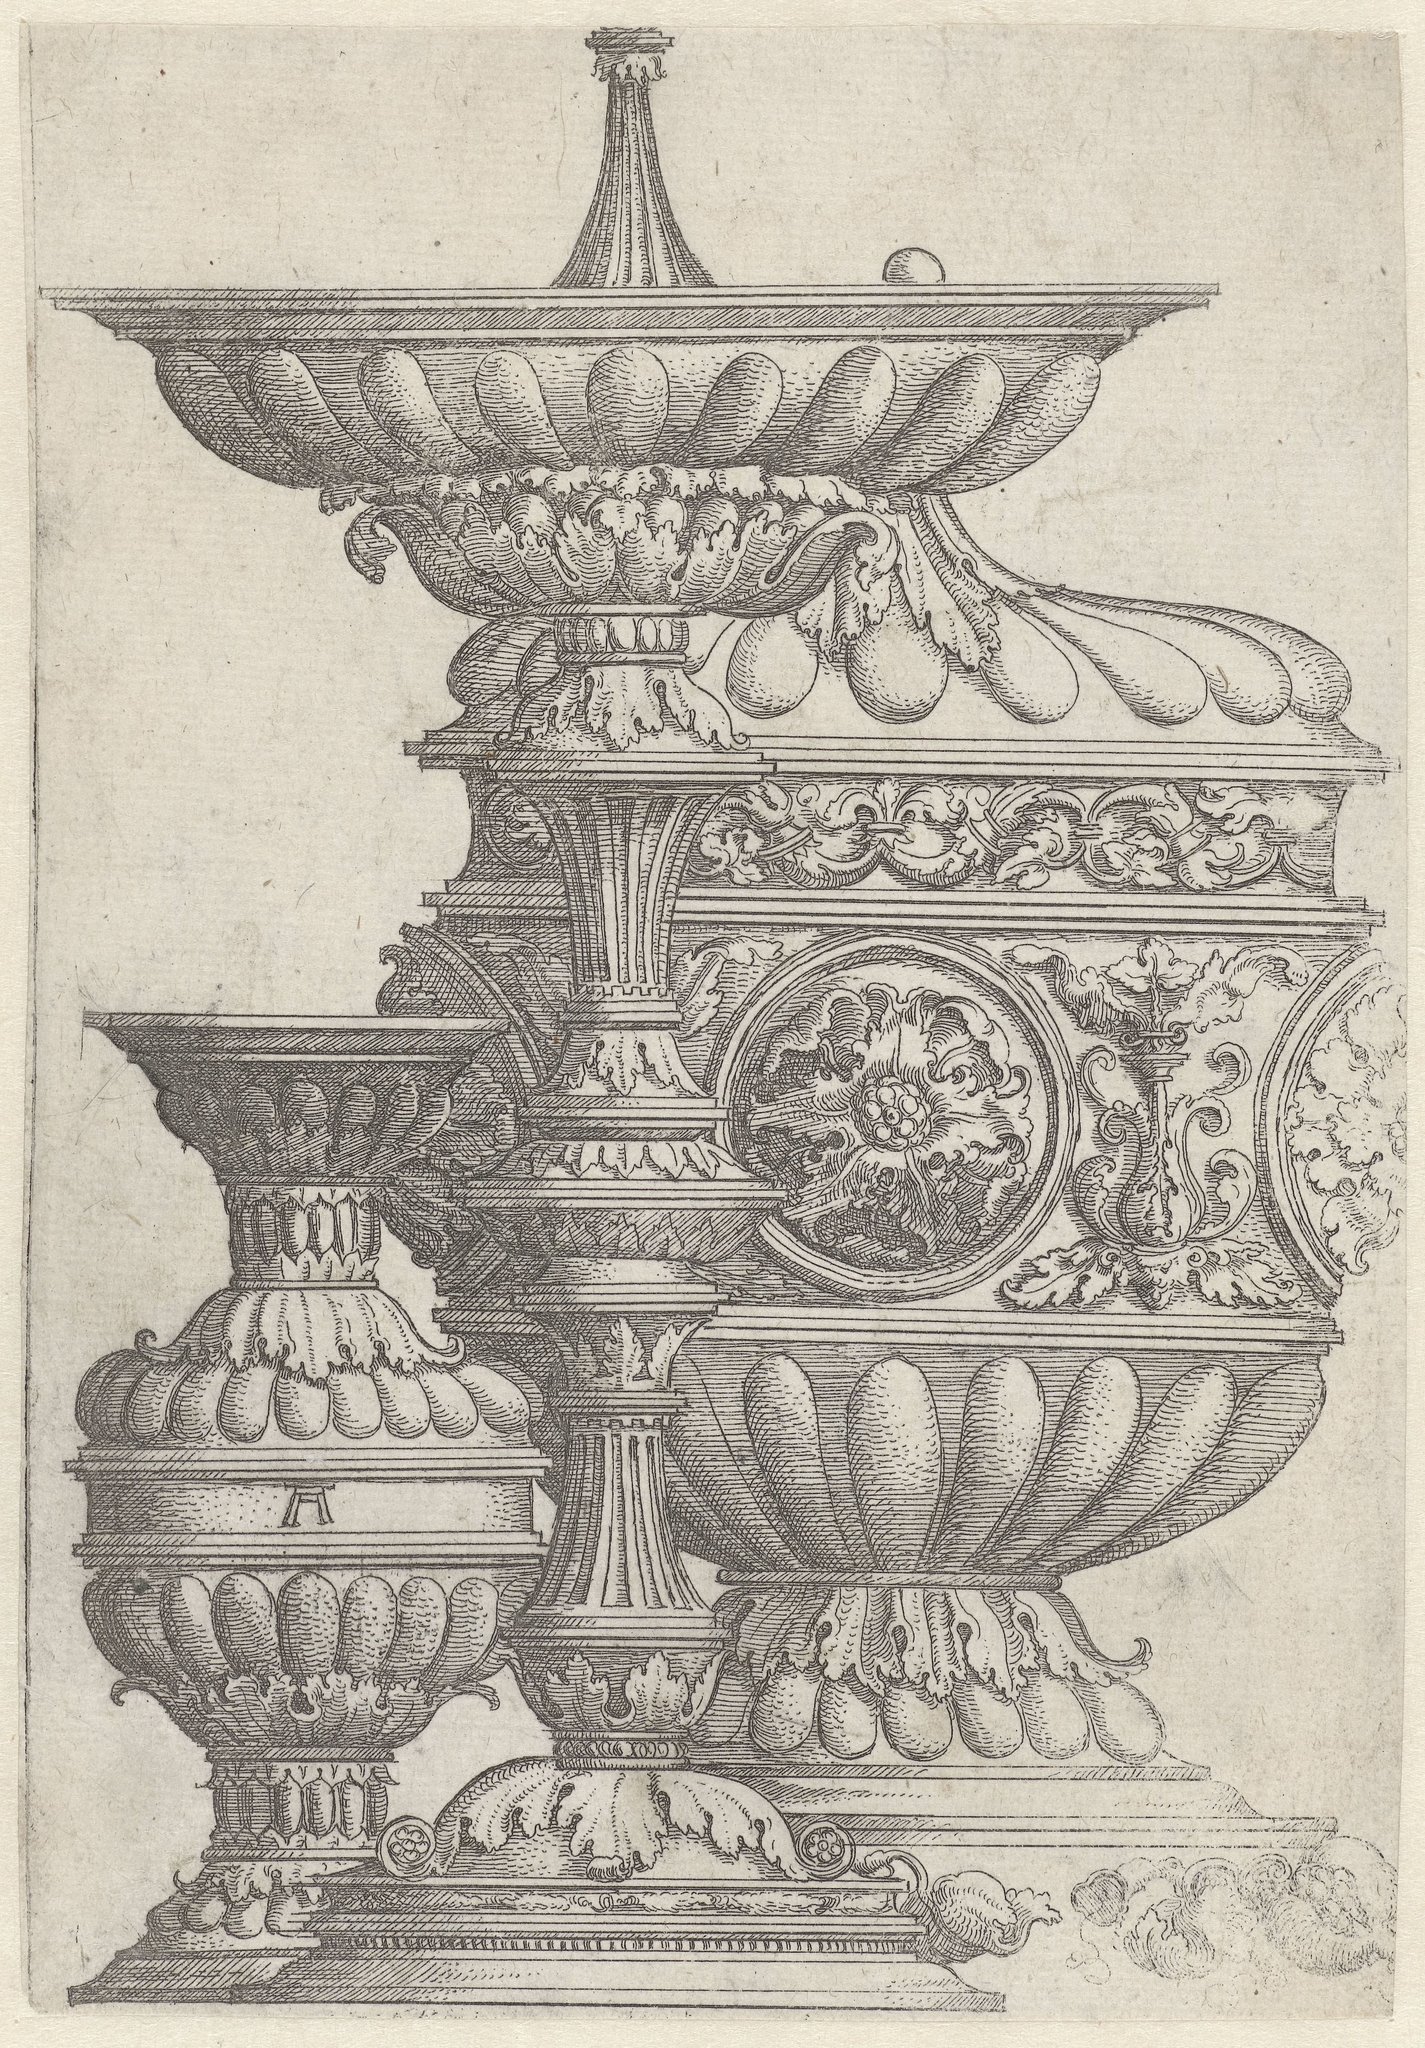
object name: print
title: Vazen, kannen en bokalen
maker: albrecht altdorfer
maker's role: draughtsman, print maker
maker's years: 1480-1538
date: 1506-1538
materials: paper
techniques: etching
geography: germany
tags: mug, beaker, goblet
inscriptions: number: ‘101’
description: Een dubbele bokaal, een schaal op een voet en een bokaal met een deksel, alle drie gedecoreerd met bladeren. Uit een serie van 22 bladen met vazen, kannen en bokalen.